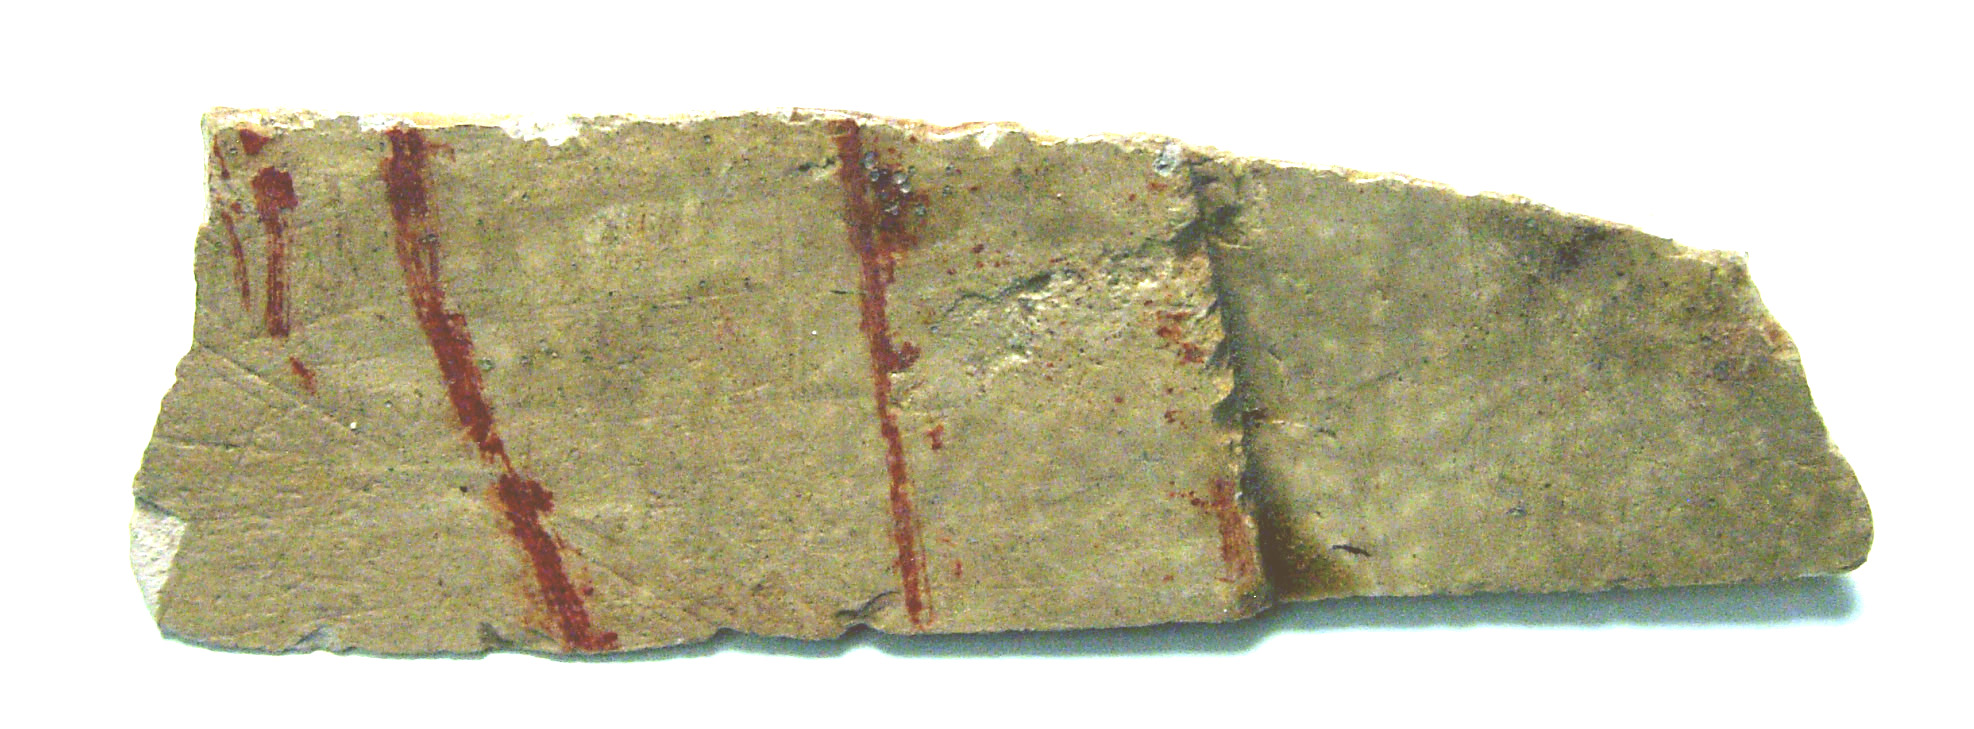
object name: relief, tomb of nespekashuty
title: Raised relief fragment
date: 664-610 BCE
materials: limestone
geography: egypt